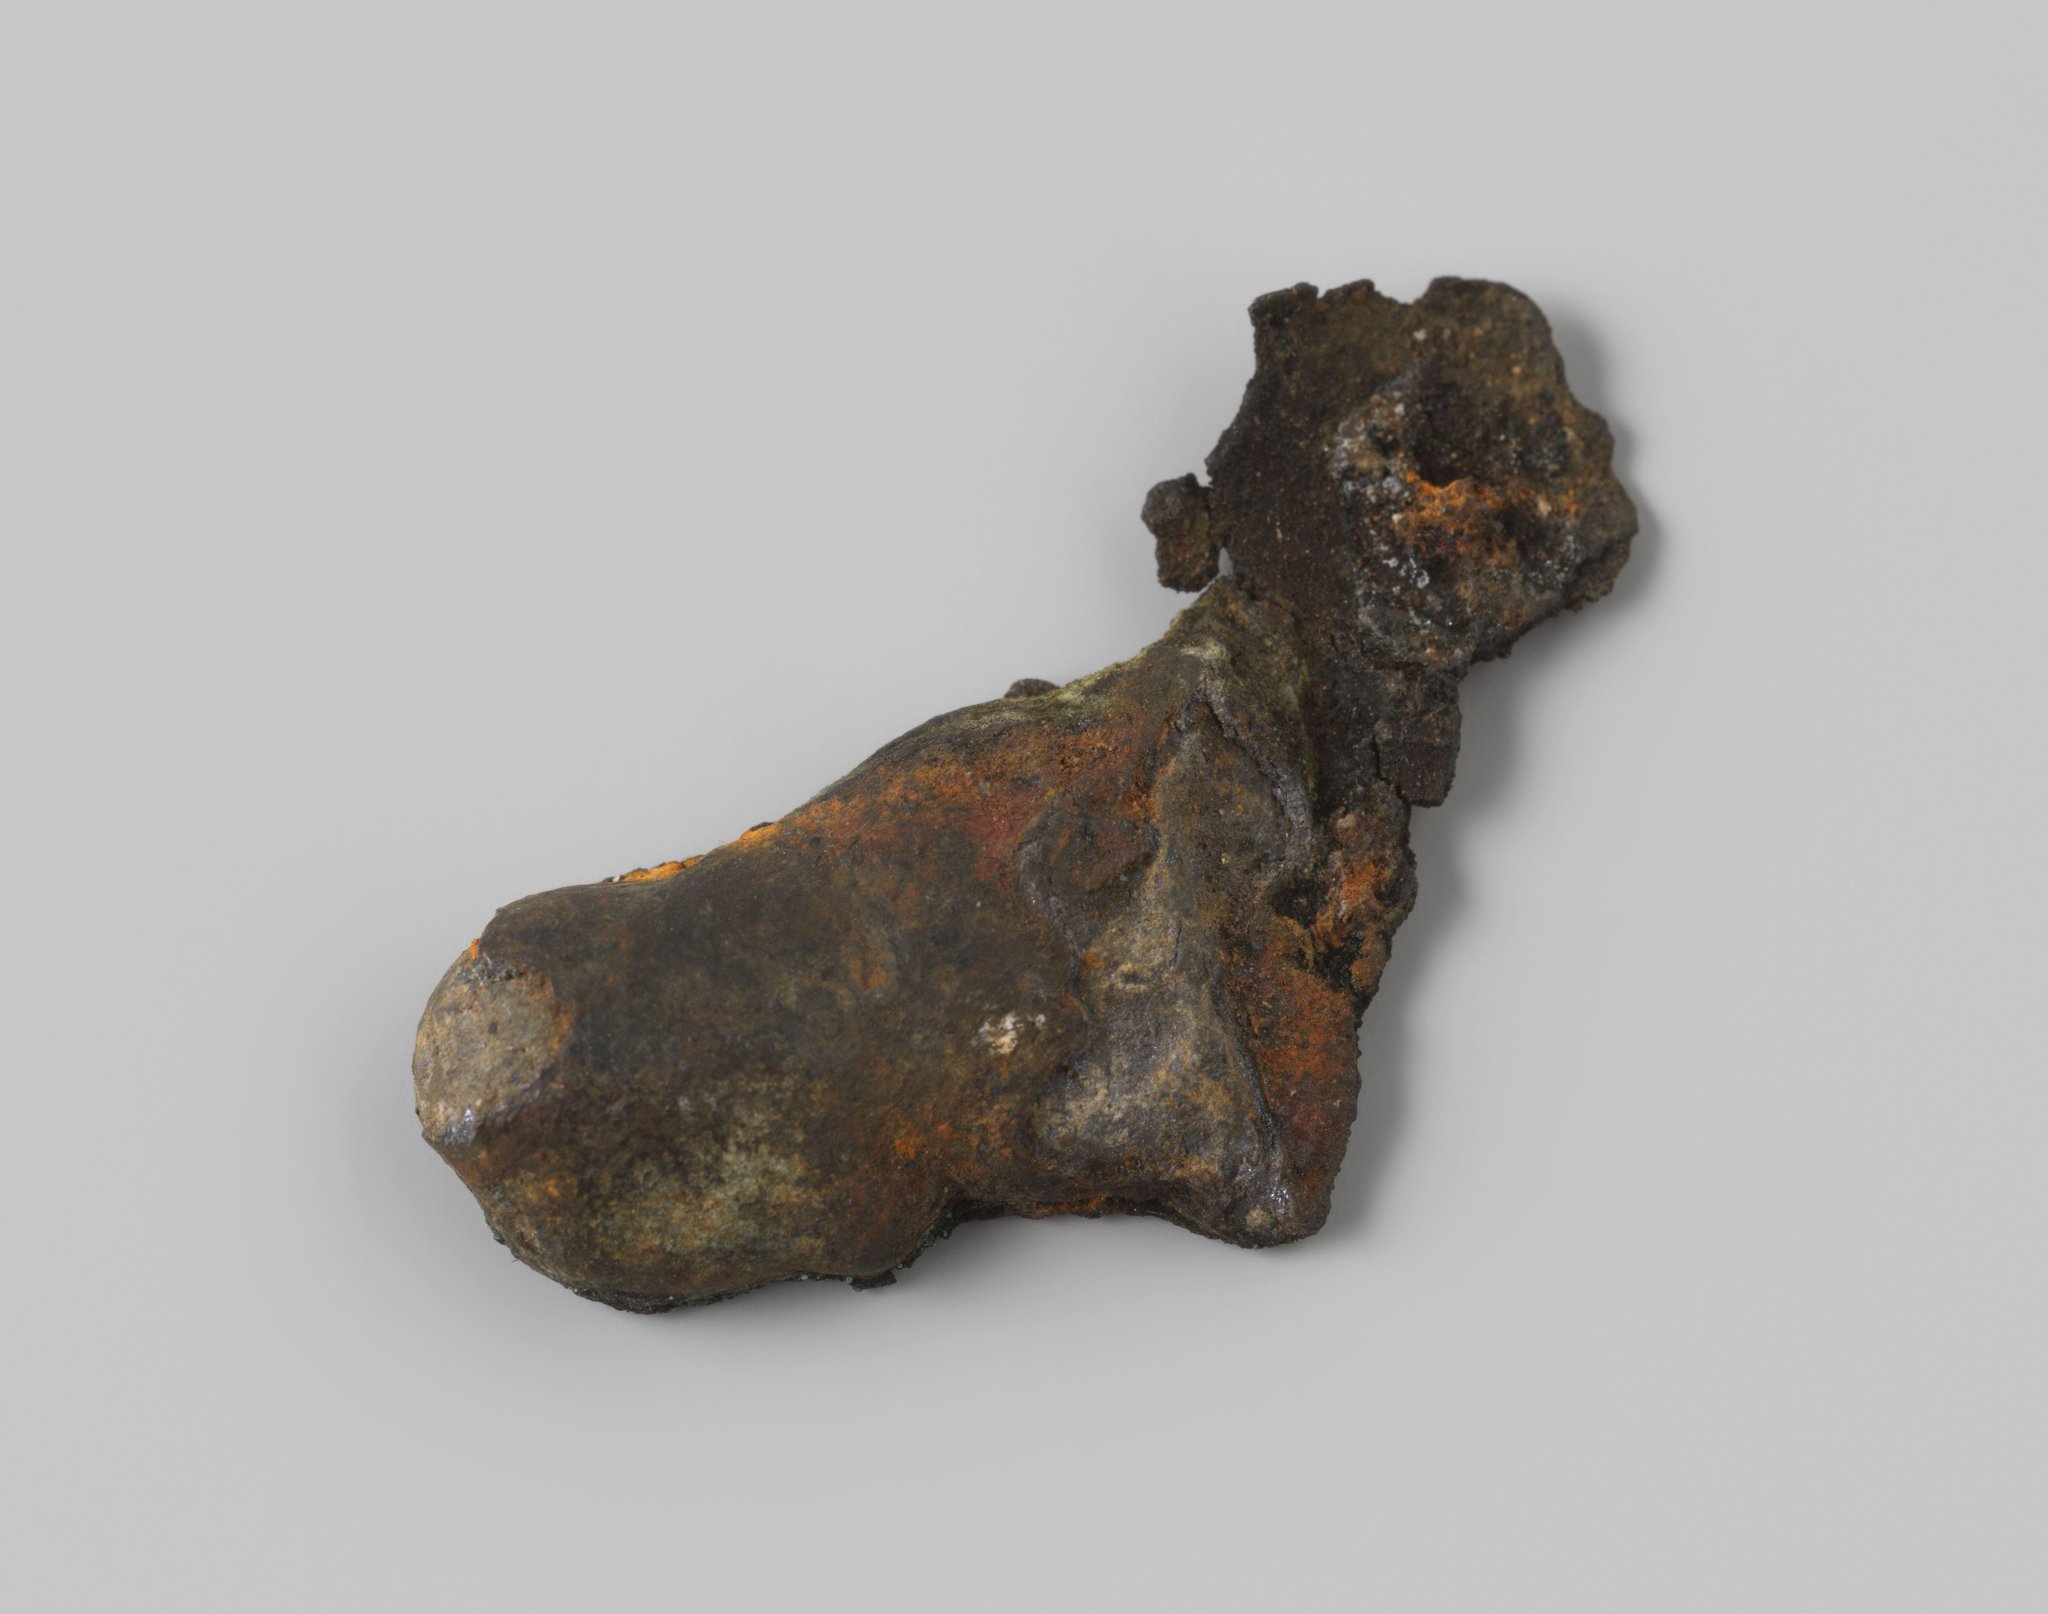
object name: cartridge shell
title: Fragment beslag van patroonhuls uit het wrak van de Oost-Indiëvaarder Hollandia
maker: Anonymous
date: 1700-1743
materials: lead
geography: netherlands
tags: verenigde oostindische compagnie, hollandia (schip), annet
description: Cartridge case, tube solder; id. NG 1979-205H549.